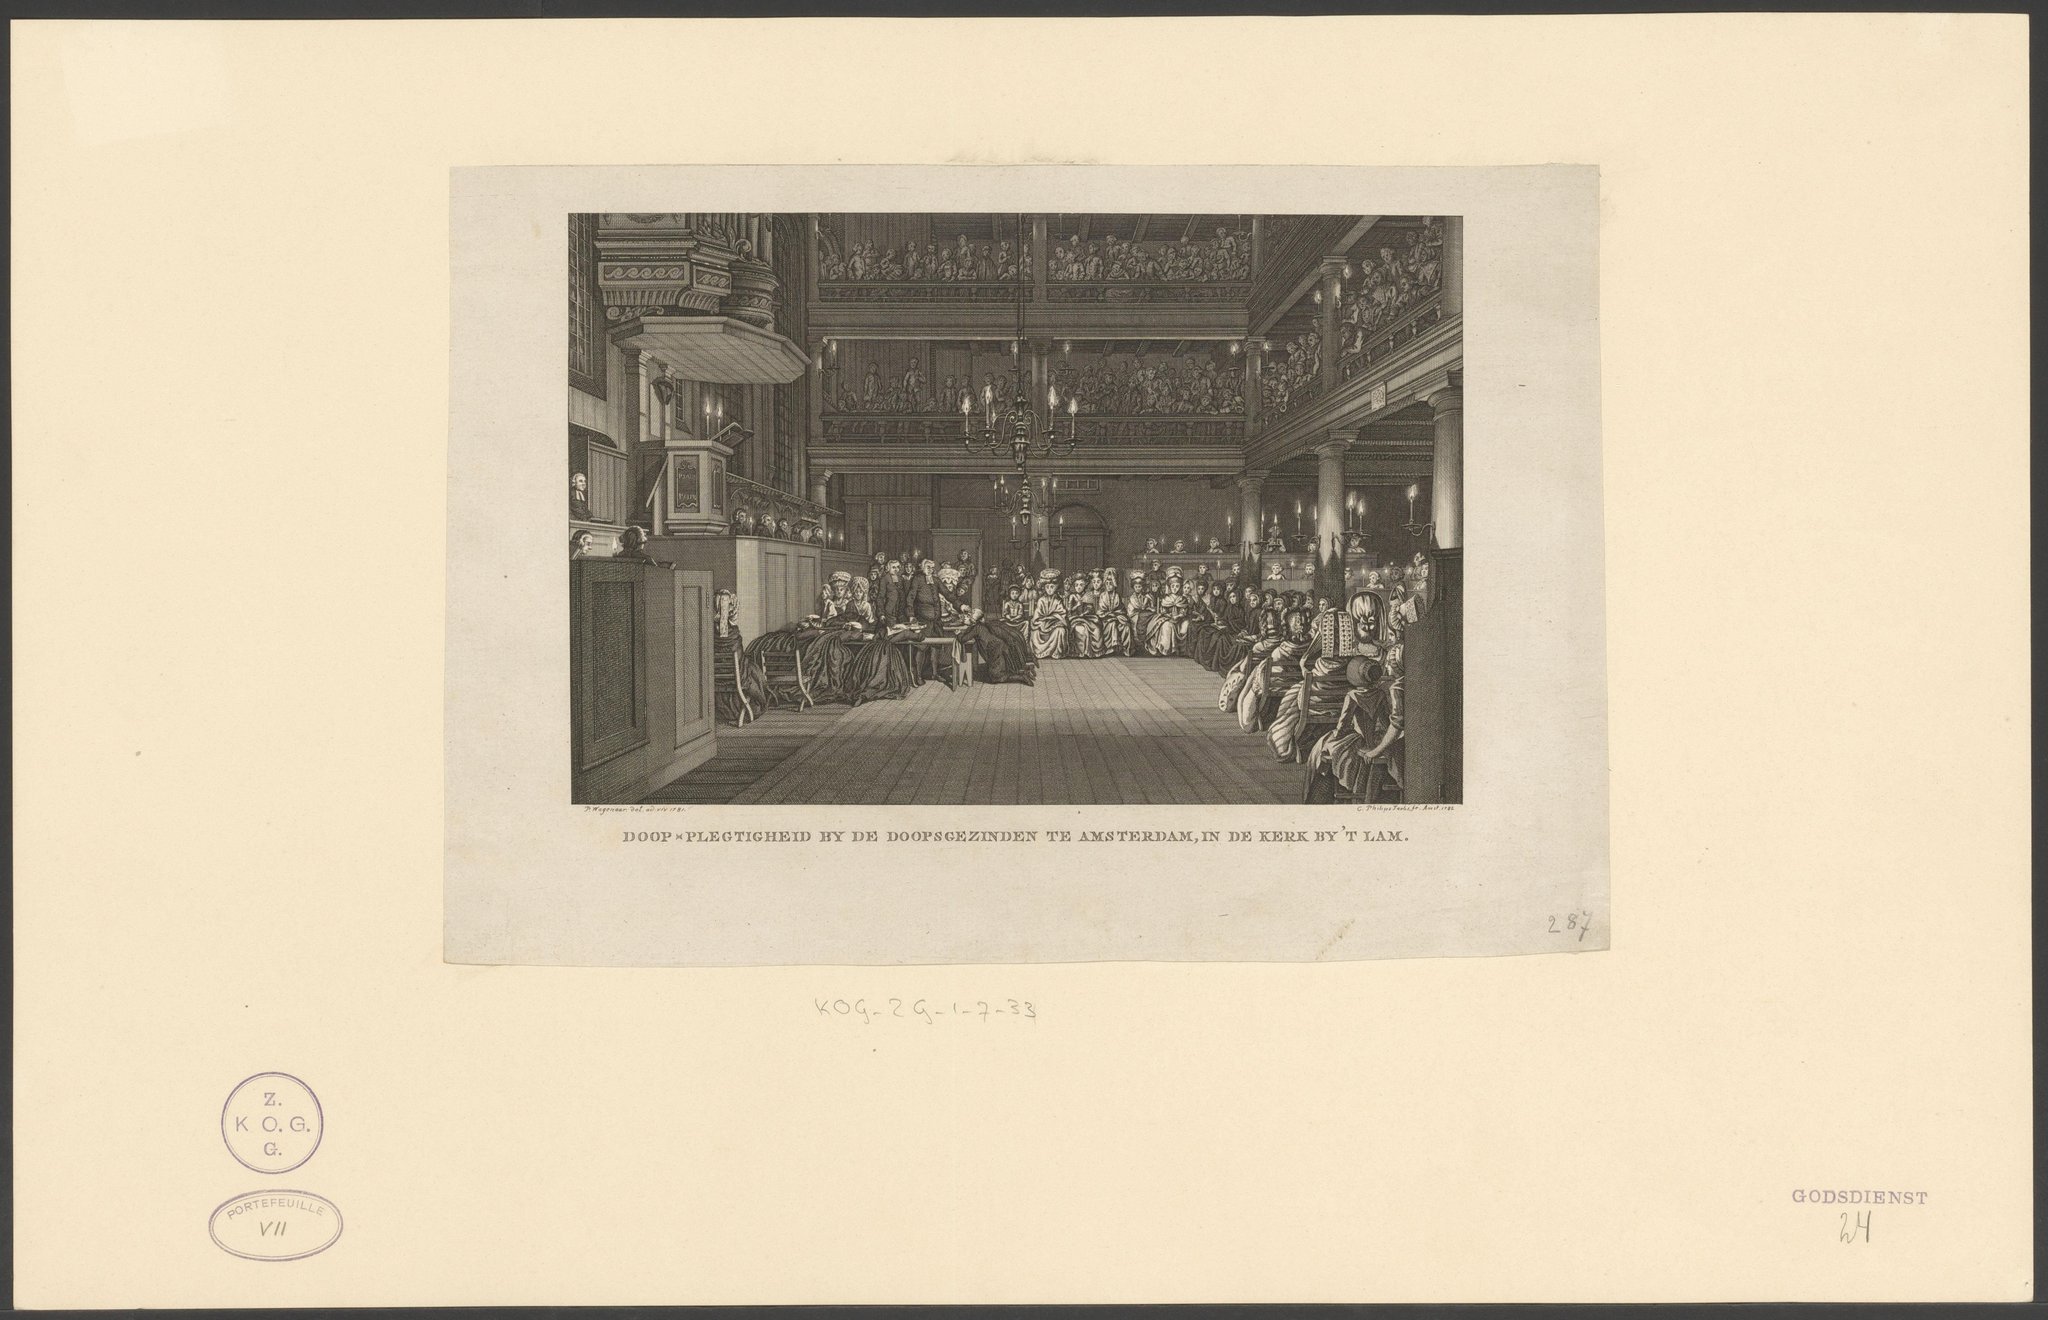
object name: print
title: Doop in de Doopsgezinde Kerk Bij 't Lam te Amsterdam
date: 1782-1785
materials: paper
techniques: engraving, etching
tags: baptism ~ protestant service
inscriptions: stamp, collector's mark: Lugt 1641, stamp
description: Kerkinterieur van de Doopsgezinde schuilkerk Bij 't Lam te Amsterdam waarin een doopceremonie plaatsvindt. De leraar besprenkelt de hoofden van enkele mannen en vrouwen. Onderwerpsrubrieken binnen de Atlas Zeden en Gewoonten: Godsdienst, Doopsgezinden.